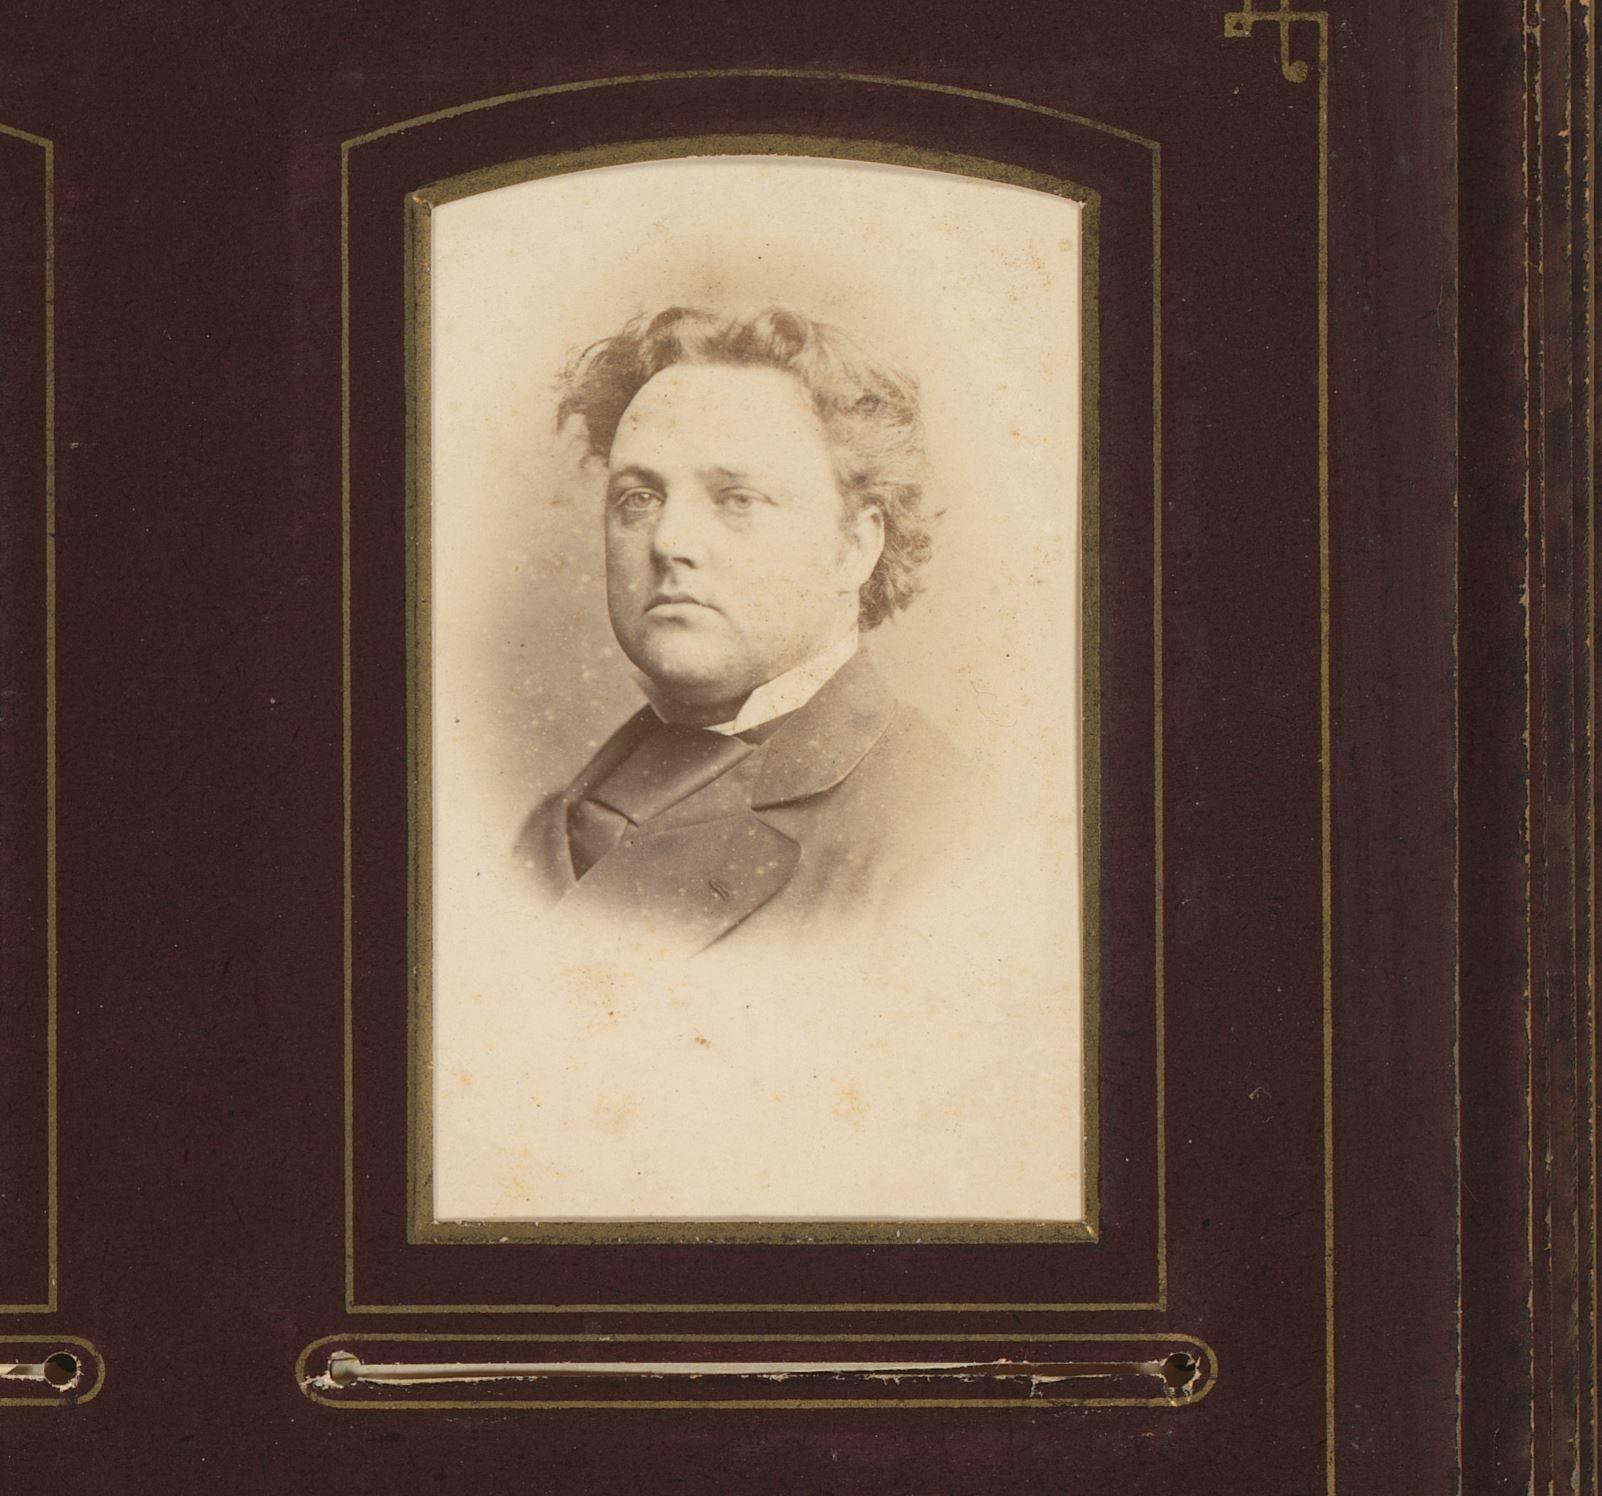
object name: photograph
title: Portret van een man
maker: albert greiner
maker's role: fotograaf, fotostudio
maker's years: 1833-1890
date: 1861-1887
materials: cardboard, photographic support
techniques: albumen print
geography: amsterdam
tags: historical persons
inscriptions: inscription: ‘A. GREINER/ Photograf/ AMSTERDAM/ NIEUWENDIJK L. 89.’